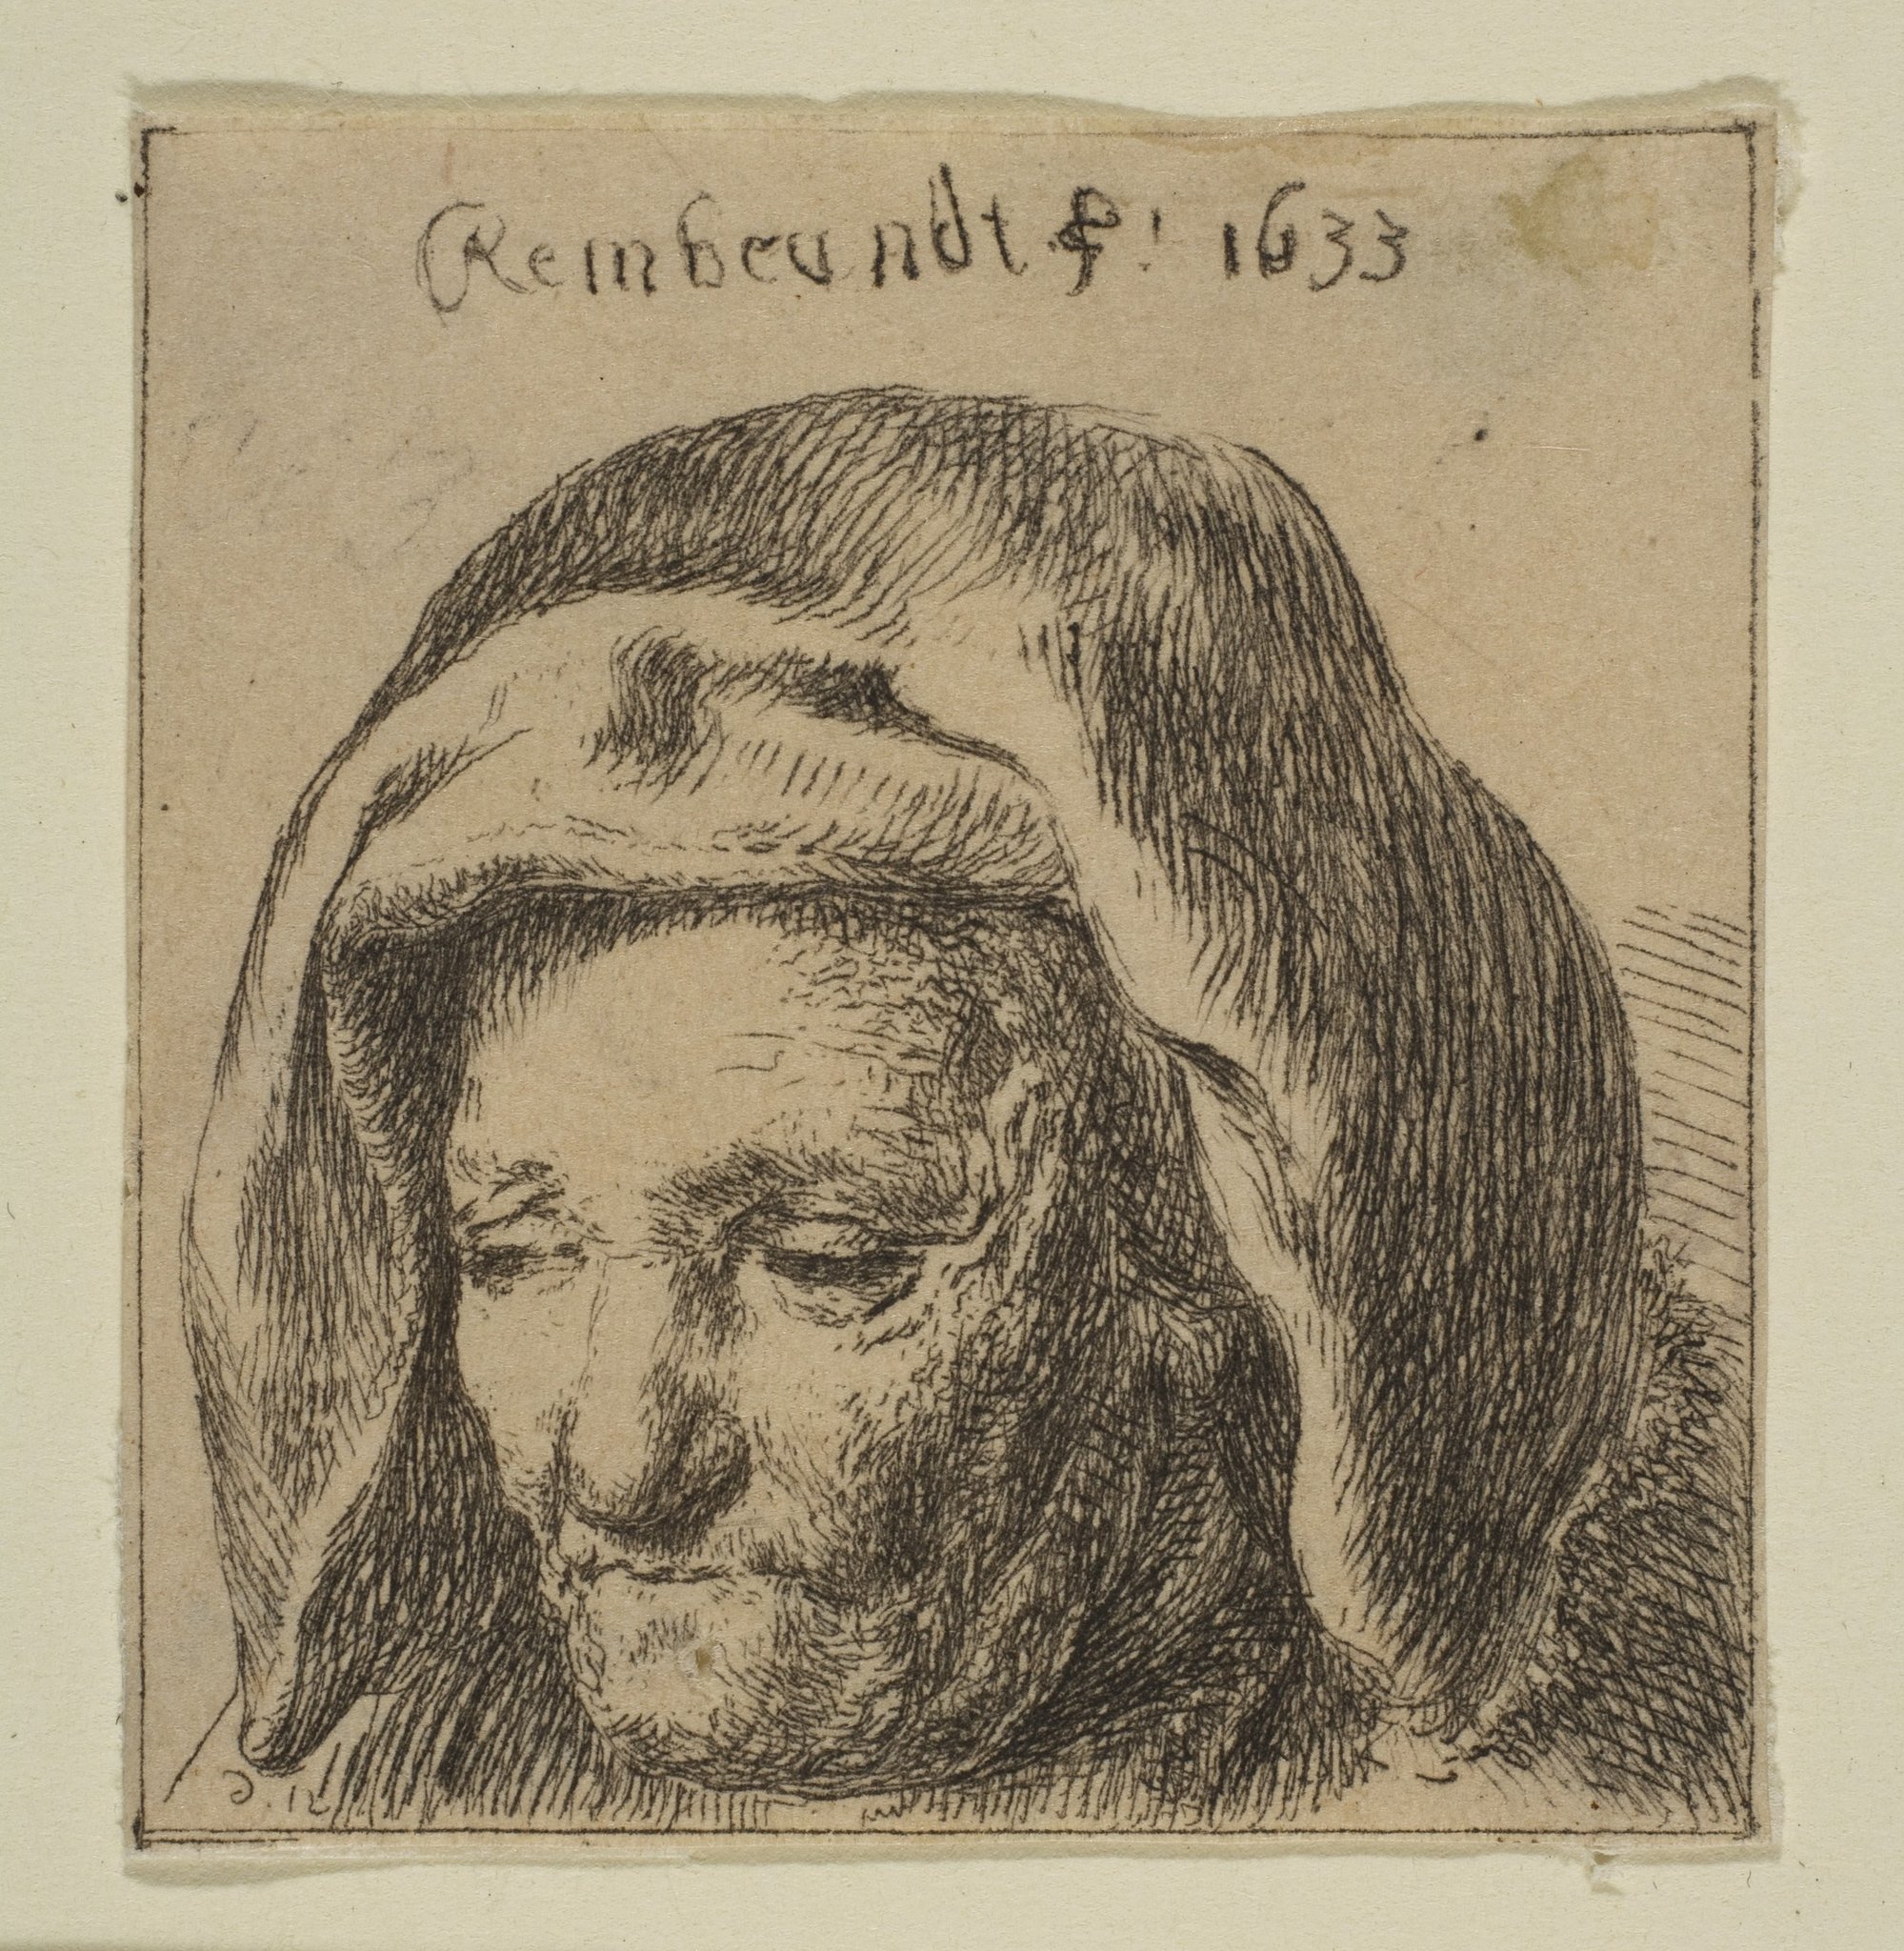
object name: print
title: Rembrandt's Mother in a Cloth Headress, Looking Down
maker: baron dominique vivant denon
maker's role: artist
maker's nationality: french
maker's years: 1747-1825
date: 1601-1700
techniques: etching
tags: women